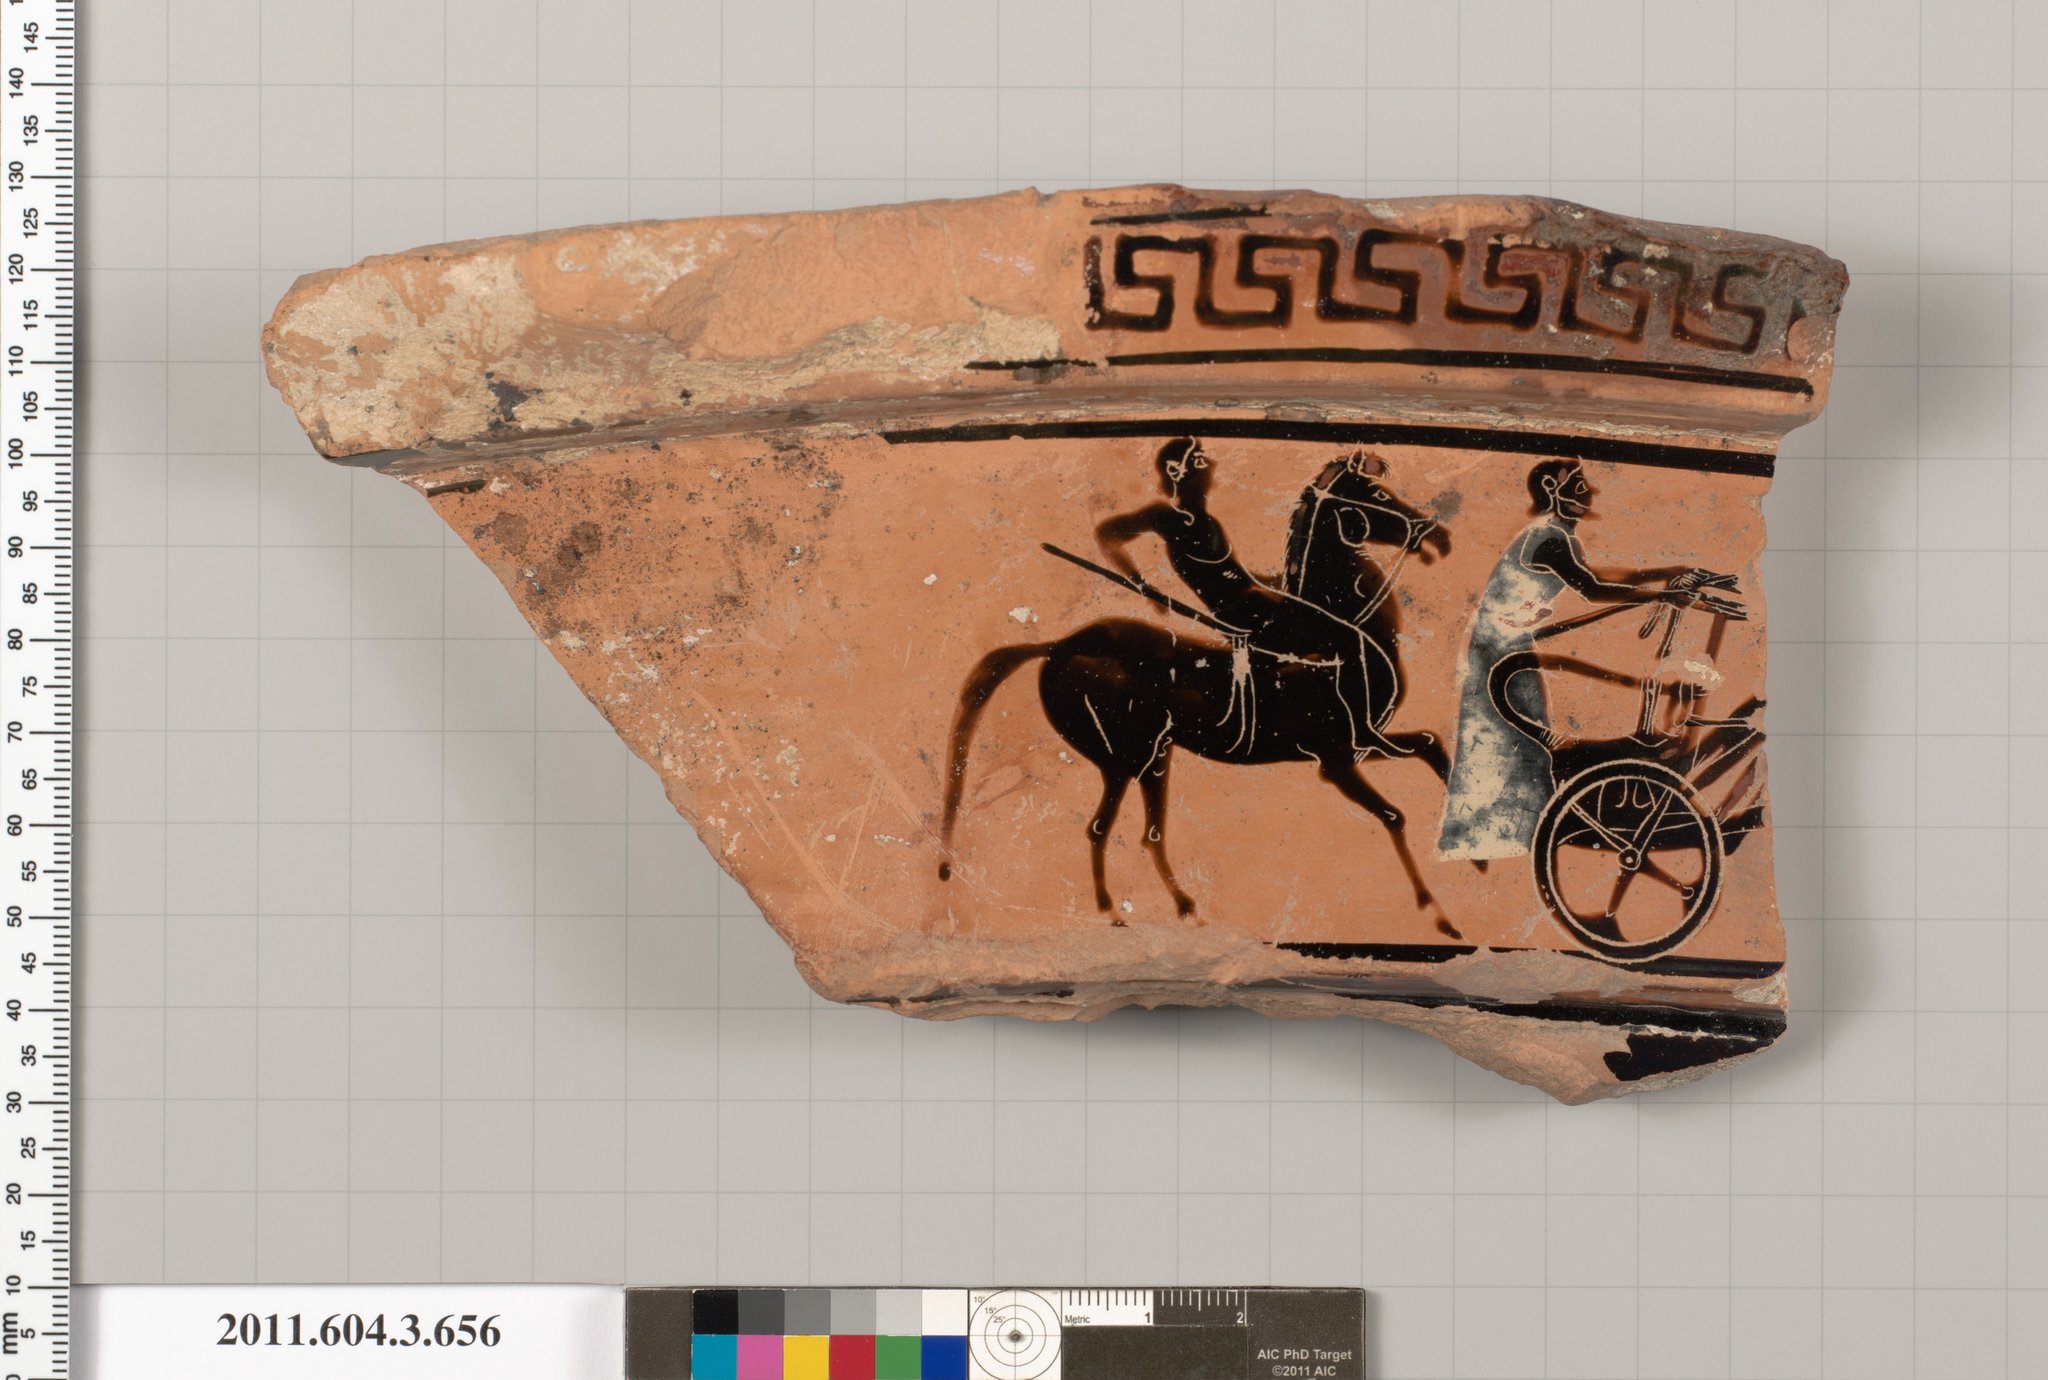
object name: volute krater fragment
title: Terracotta fragment of a volute-krater (bowl for mixing wine and water)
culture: greek, attic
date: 534-468 BCE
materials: terracotta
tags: men,horses,chariots